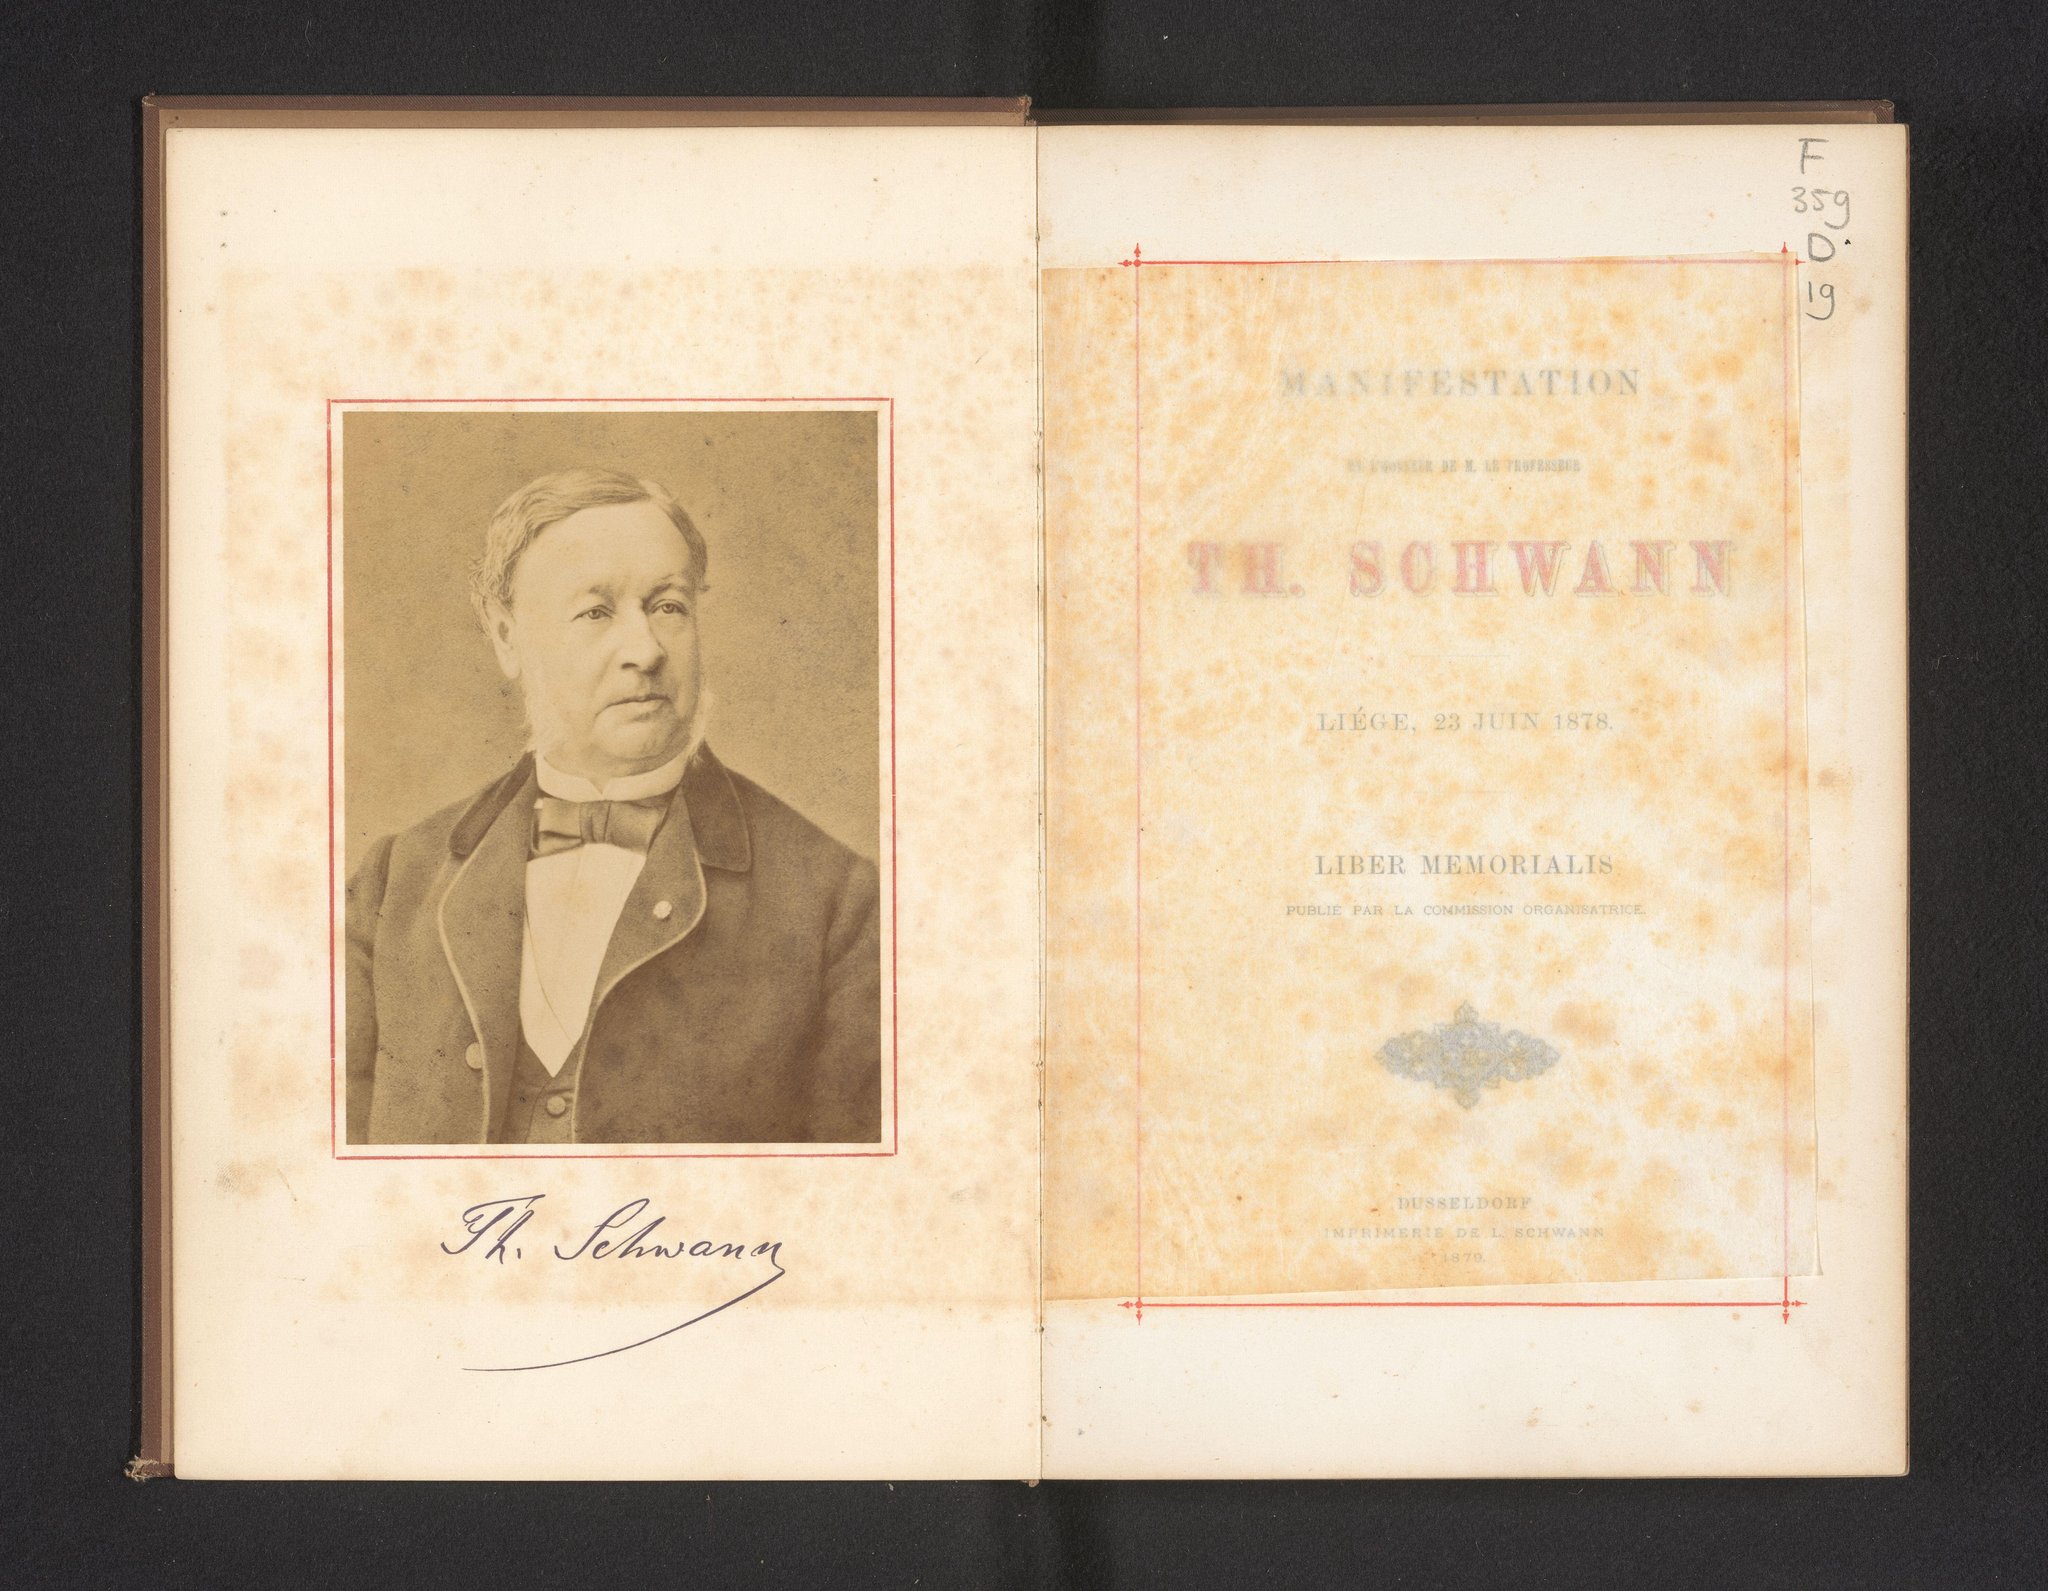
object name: photograph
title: Portret van Th. Schwann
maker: Anonymous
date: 1874-1879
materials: photographic support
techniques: albumen print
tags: cologne, historical persons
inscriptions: signature: ‘Th. Schwann’